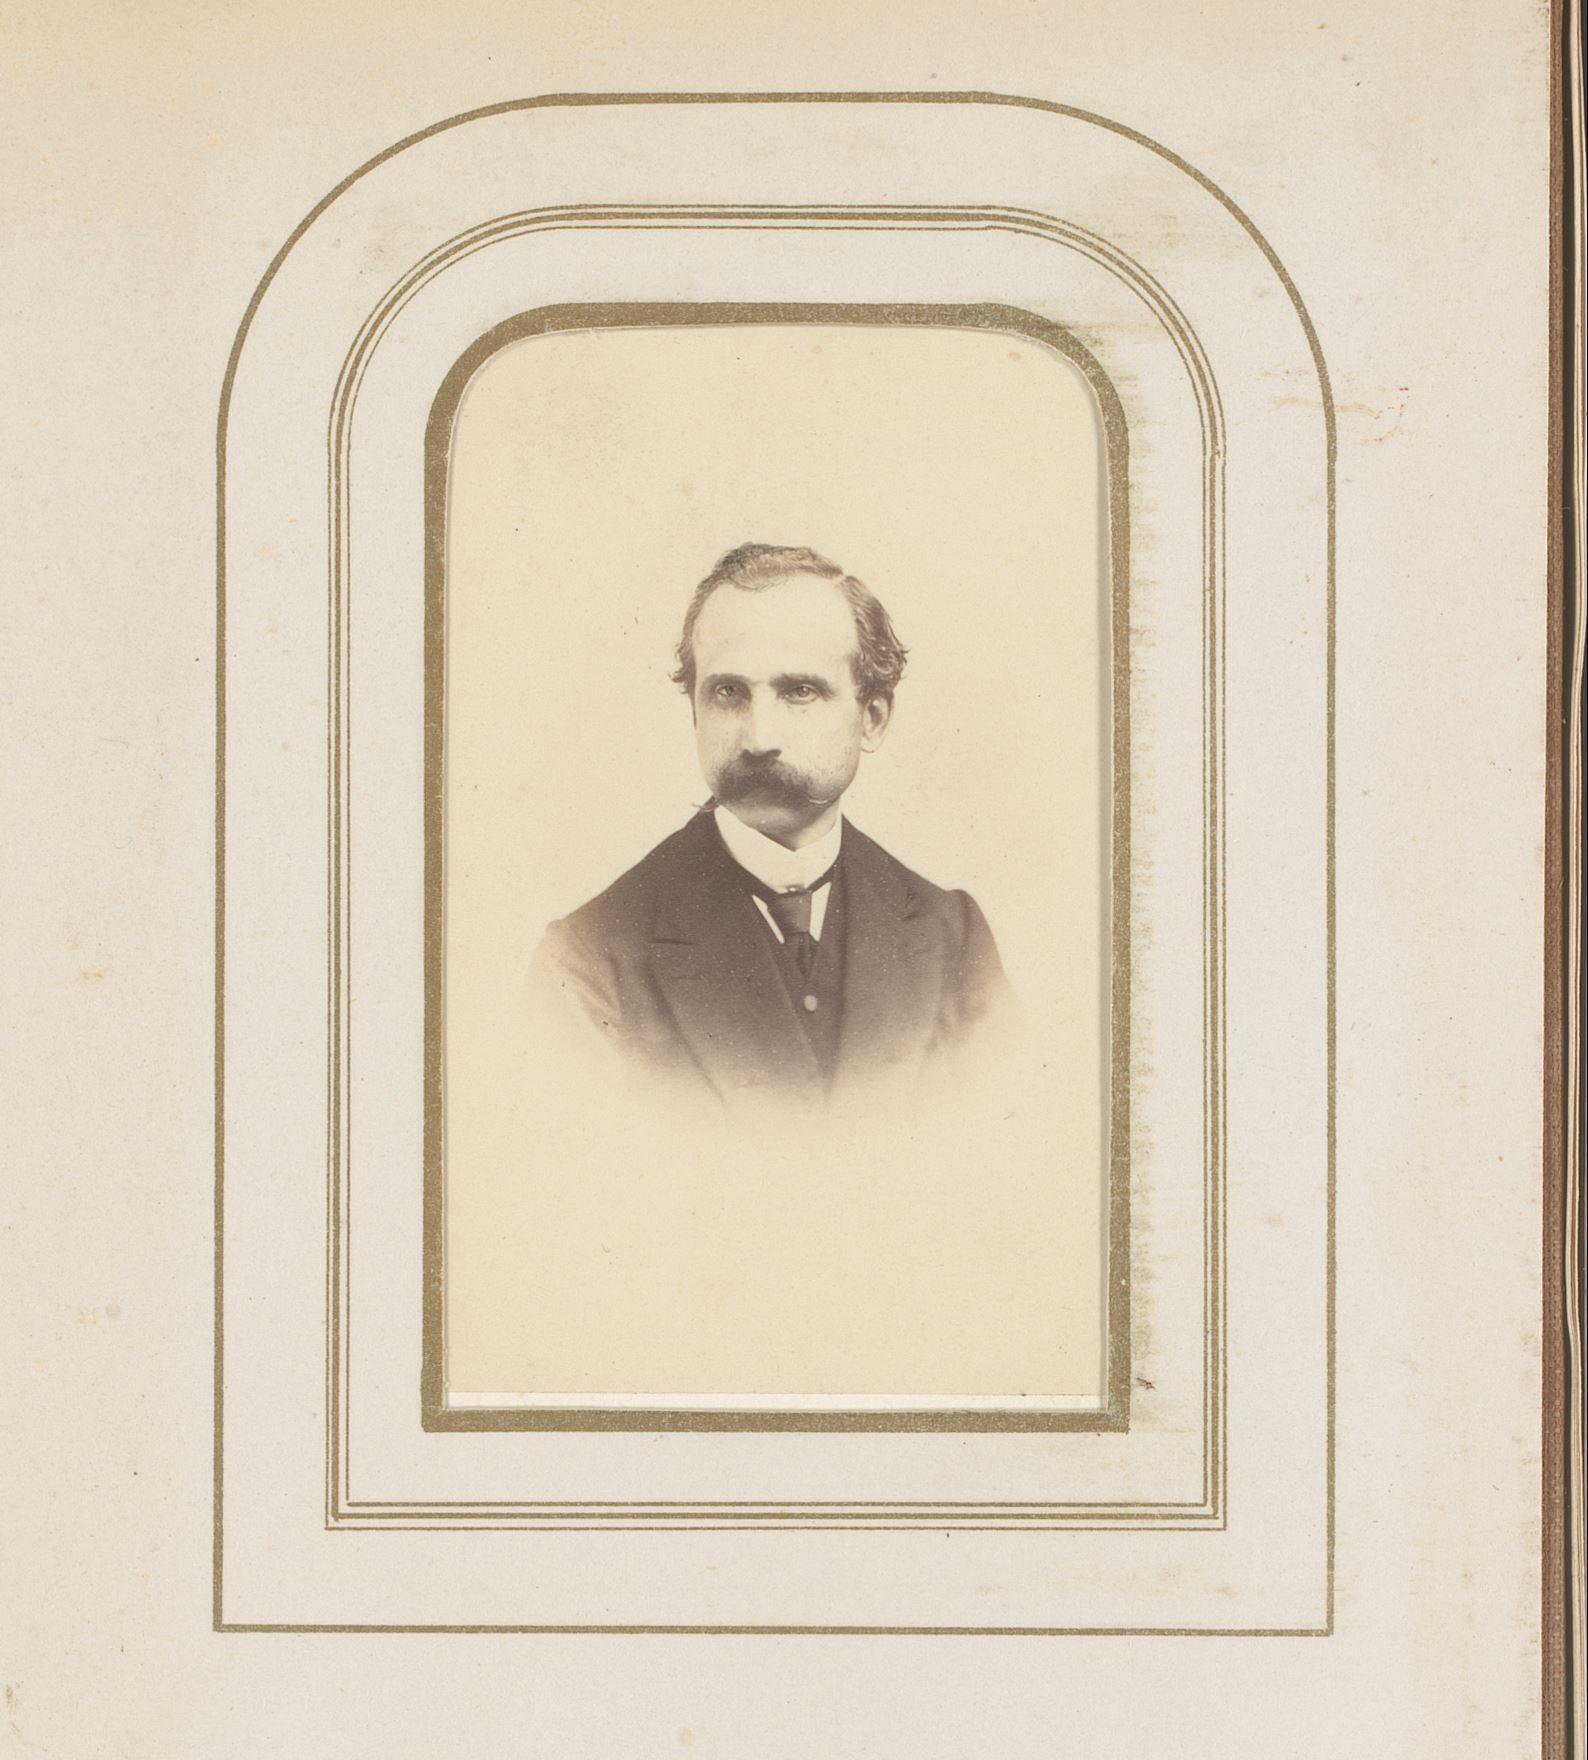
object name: photograph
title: Portret van een man met snor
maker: egide-françois billotte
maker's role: fotograaf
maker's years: 1828-1911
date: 1870-1875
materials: cardboard, photographic support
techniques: albumen print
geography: brussels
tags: moustache, historical persons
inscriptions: inscription: ‘Atelier de photographie/ E. Billotte/ 4, Montague aux Herbes Potageres/ Bruxelles/ Anciennement rue de la Reine’